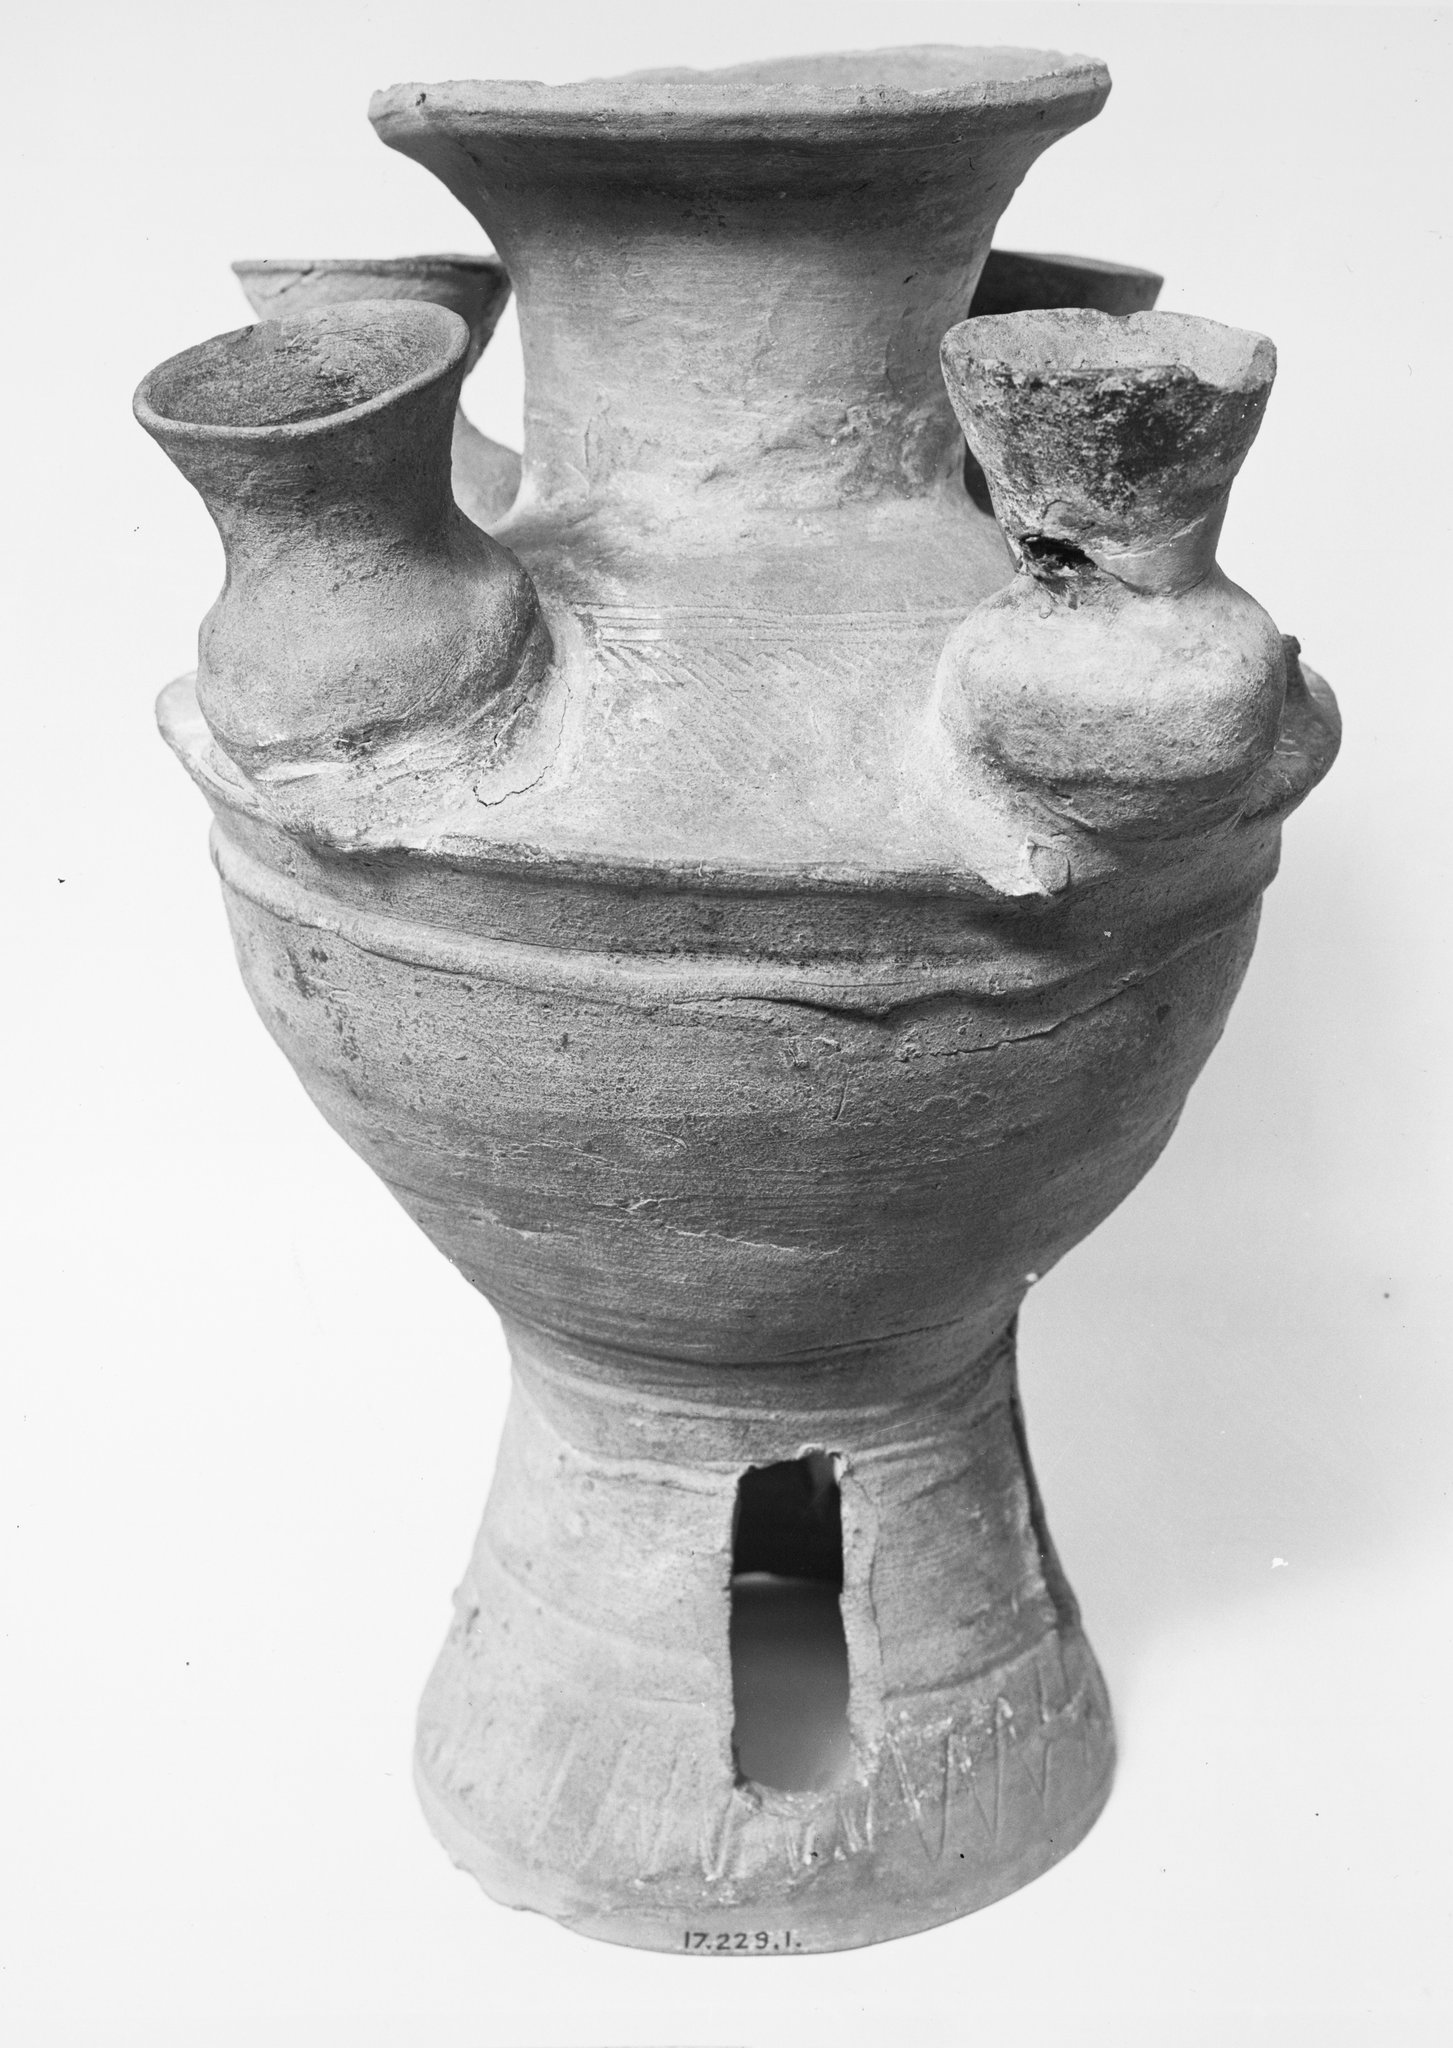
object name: jar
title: Offering Jar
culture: japanese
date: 401-600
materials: pottery